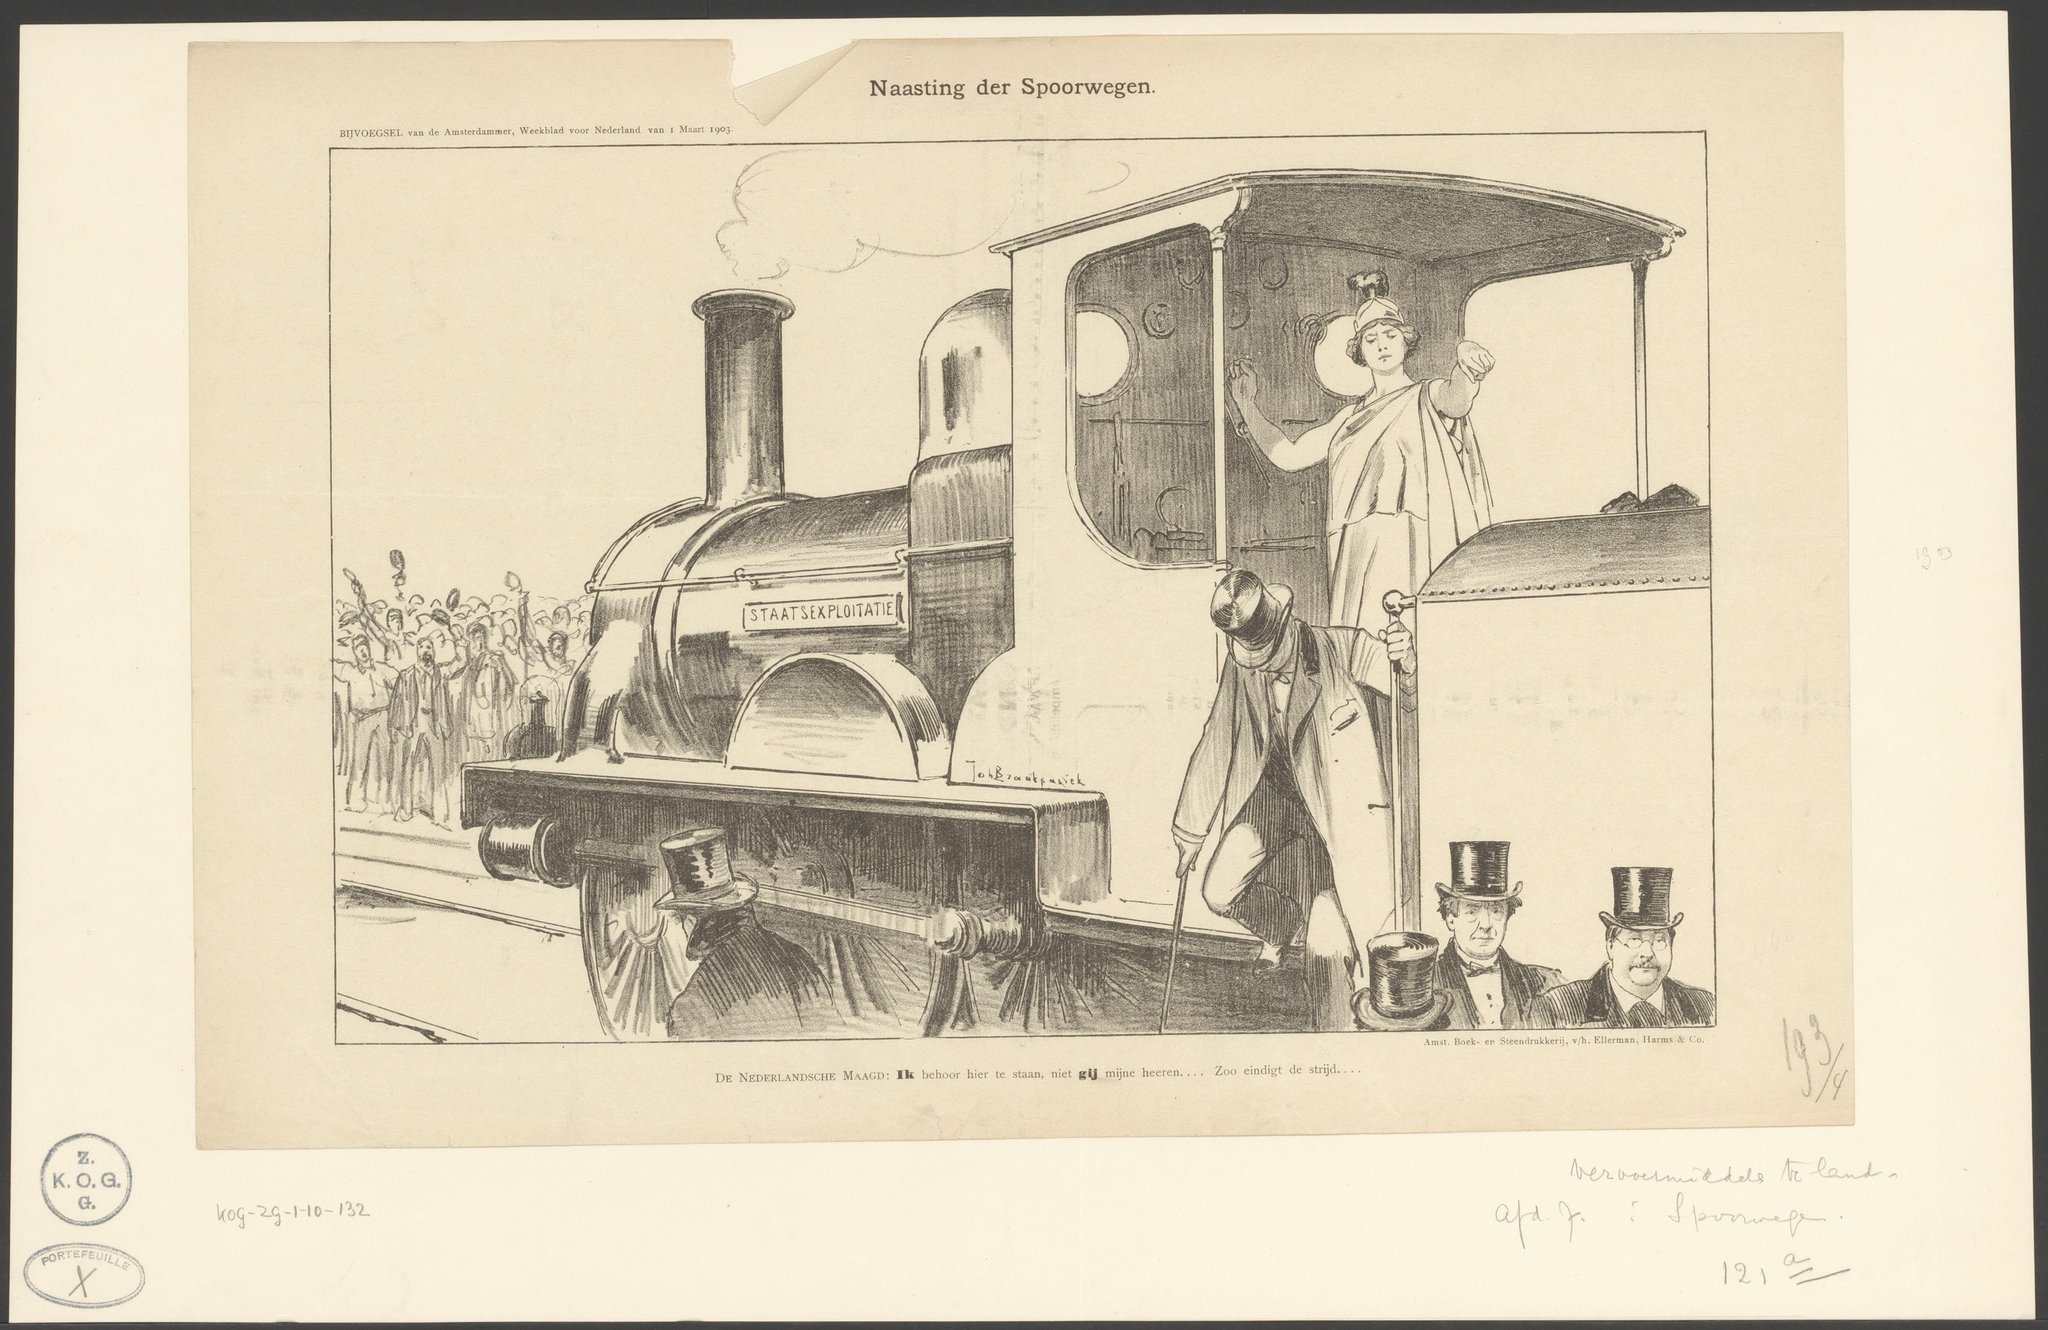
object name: print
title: Naasting der Spoorwegen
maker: johan braakensiek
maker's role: draughtsman, print maker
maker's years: 1858-1940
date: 1903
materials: paper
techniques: lithograph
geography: amsterdam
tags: locomotive, personifications of countries, nations, states, districts, etc., strike (political demonstration), political caricatures and satires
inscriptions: stamp, collector's mark: Lugt 1641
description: De Nederlandse Maagd neemt het bestuur van de spoorwegen over en stuurt de hoge heren de laan uit. Het spoorwegpersoneel staat langs het spoor te juichen. Naar aanleiding van de recente stakingen. Onderwerpsrubrieken binnen de Atlas Zeden en Gewoonten: Handel, nijverheid en verkeer, Vervoermiddelen te land en te water, vervoermiddelen te land, Spoorwegen.